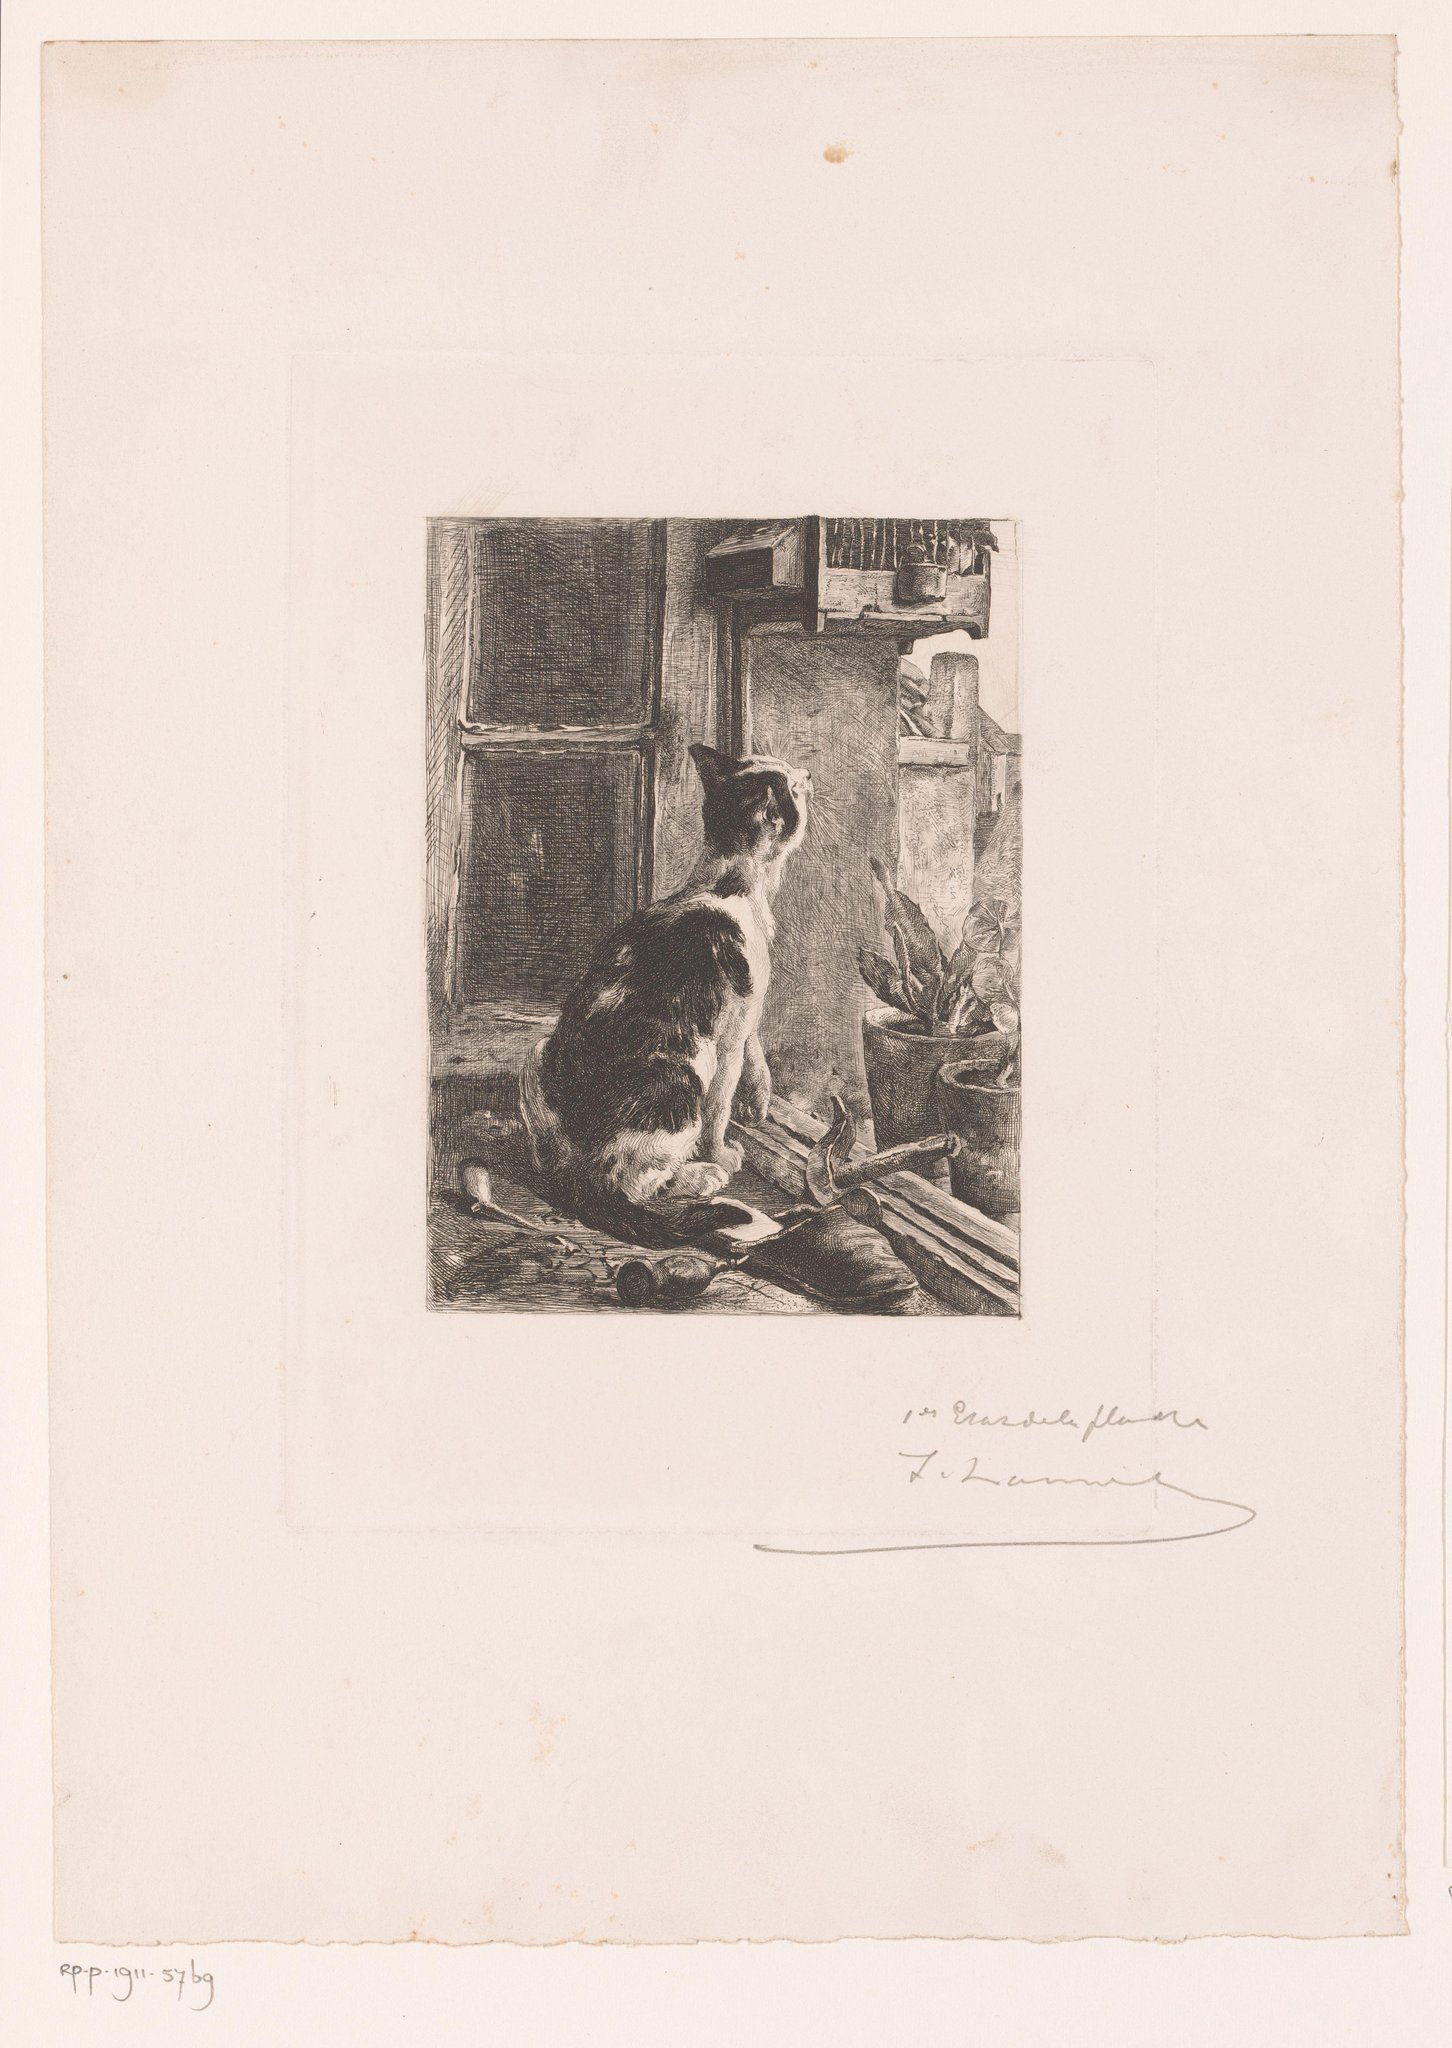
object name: print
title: Schoenmakerswerkplaats met kat in de vensterbank, op de loer bij een vogelkooi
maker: frans lauwers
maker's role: print maker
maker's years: 1854-1931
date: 1864-1890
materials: paper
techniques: etching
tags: cat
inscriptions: annotation: ‘1er Etat de la planche’, collector's mark: Lugt 2228